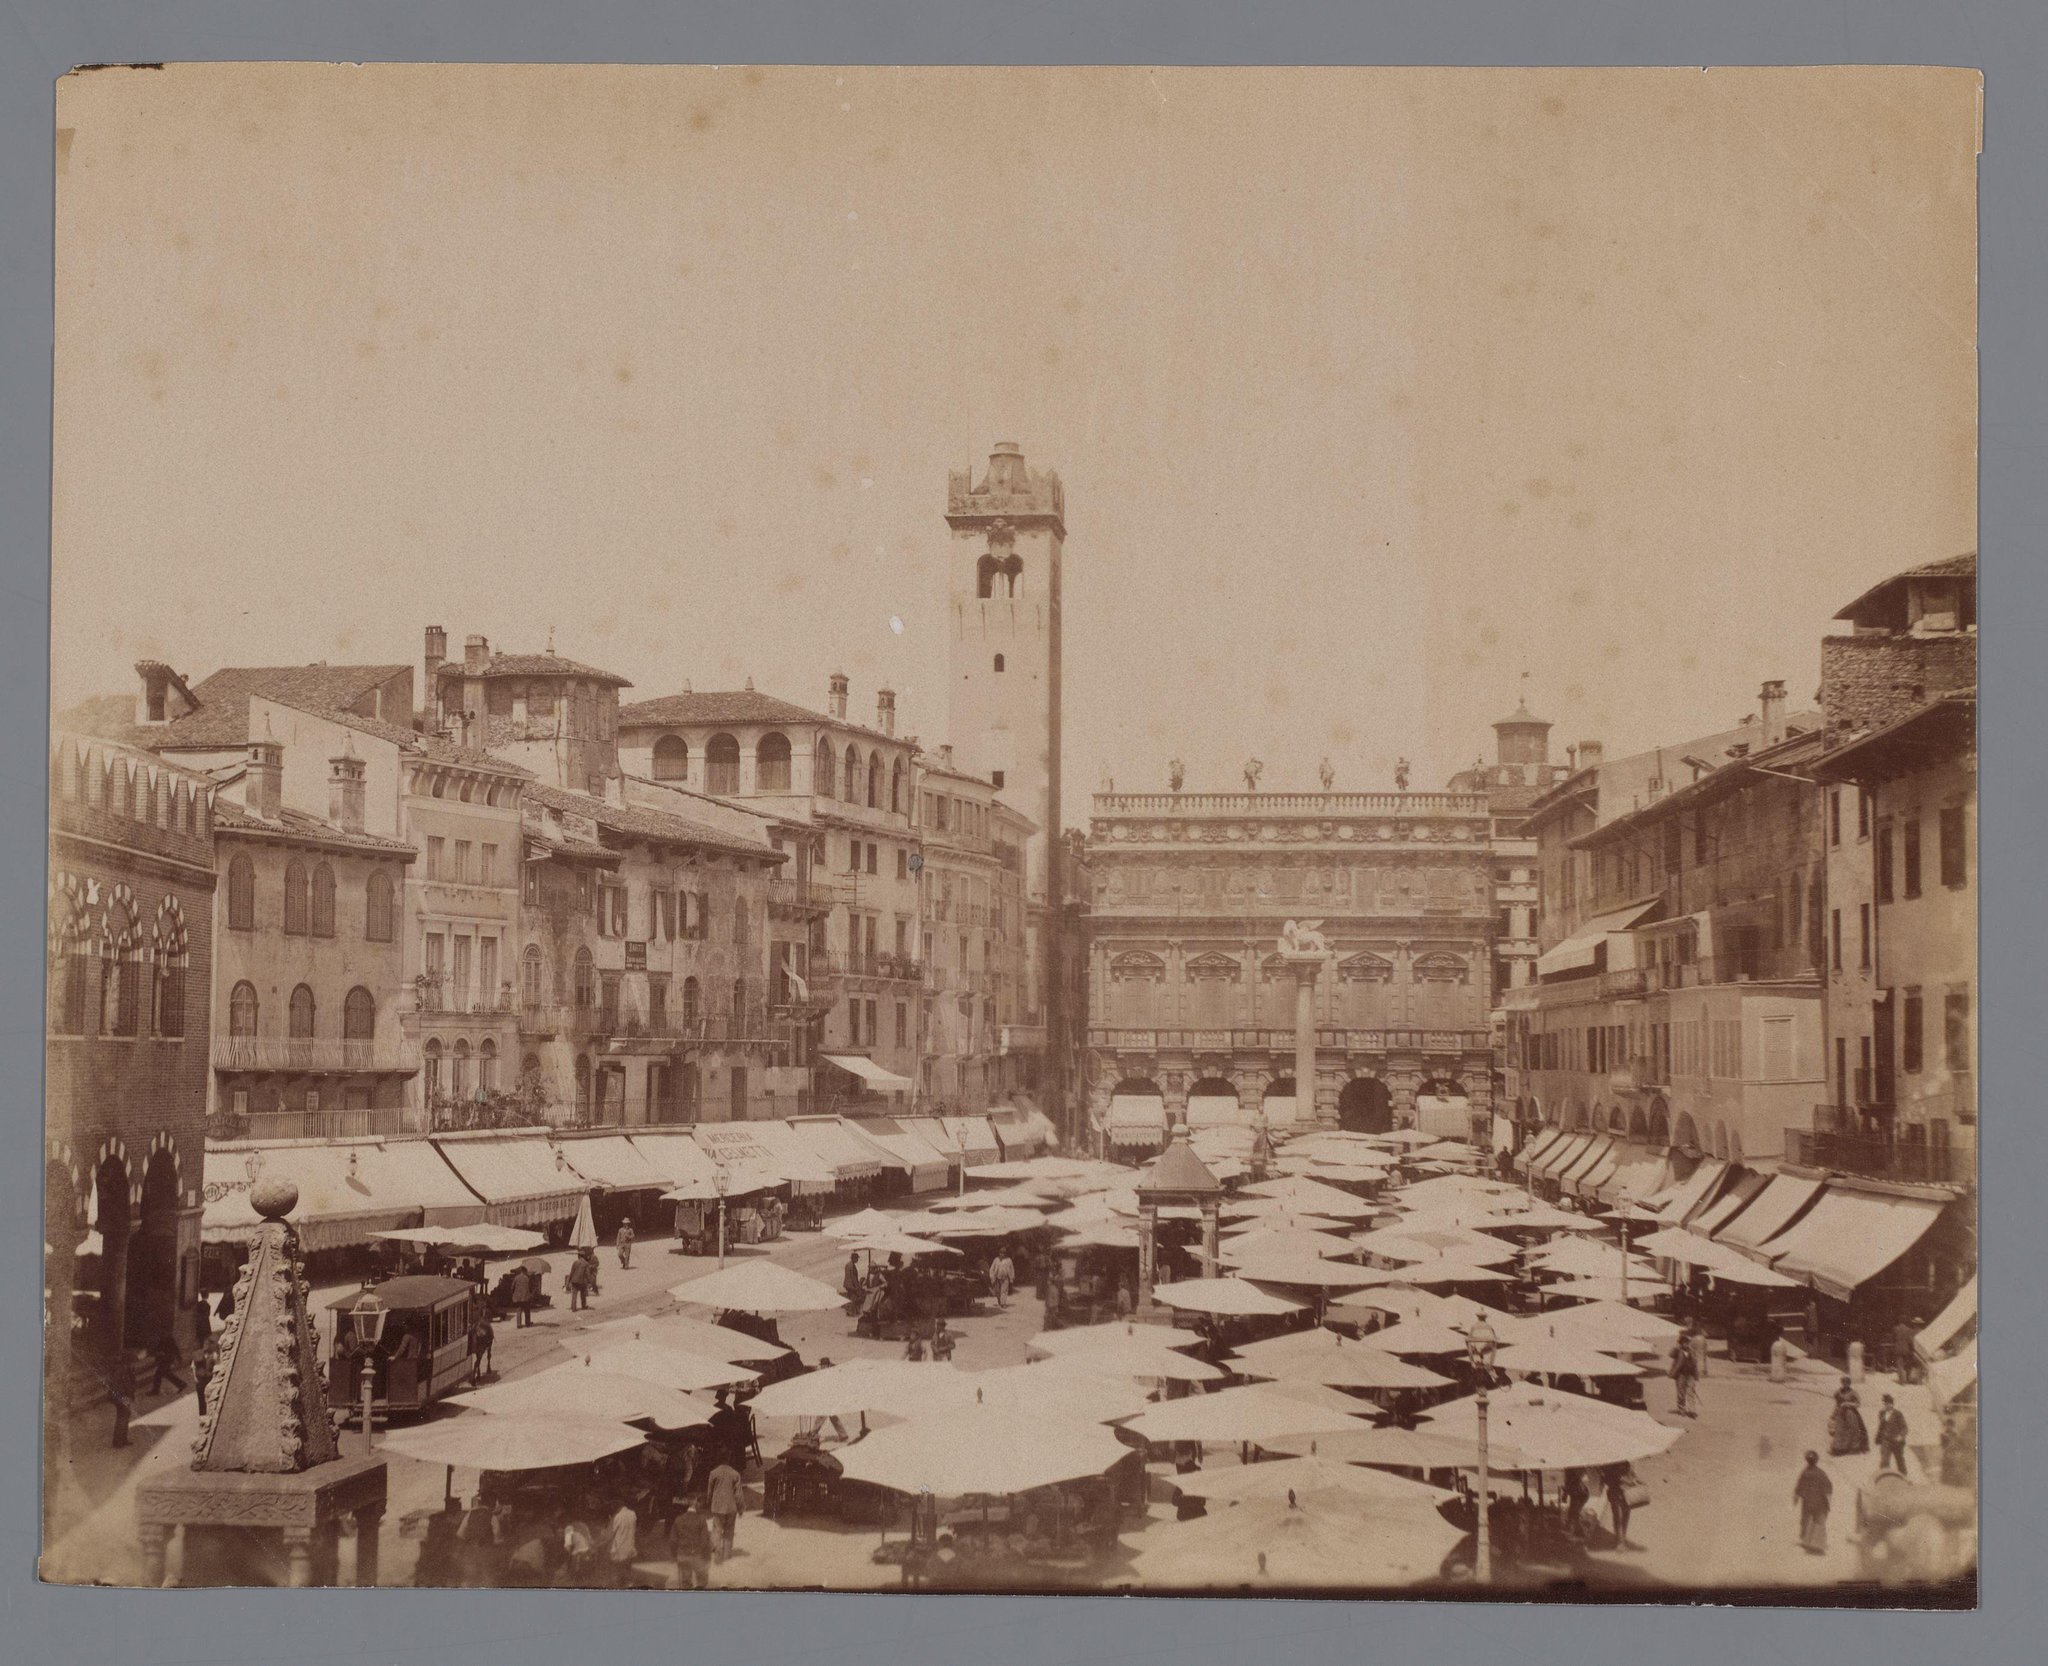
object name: photograph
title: Marktplein te Verona, Italië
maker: Anonymous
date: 1851-1900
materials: cardboard, paper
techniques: albumen print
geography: verona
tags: square, place, circus, etc., market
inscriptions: number: ‘13’, inscription: ‘Verona - Mercato [...] Erbe [?]’, inscription: ‘Verona’